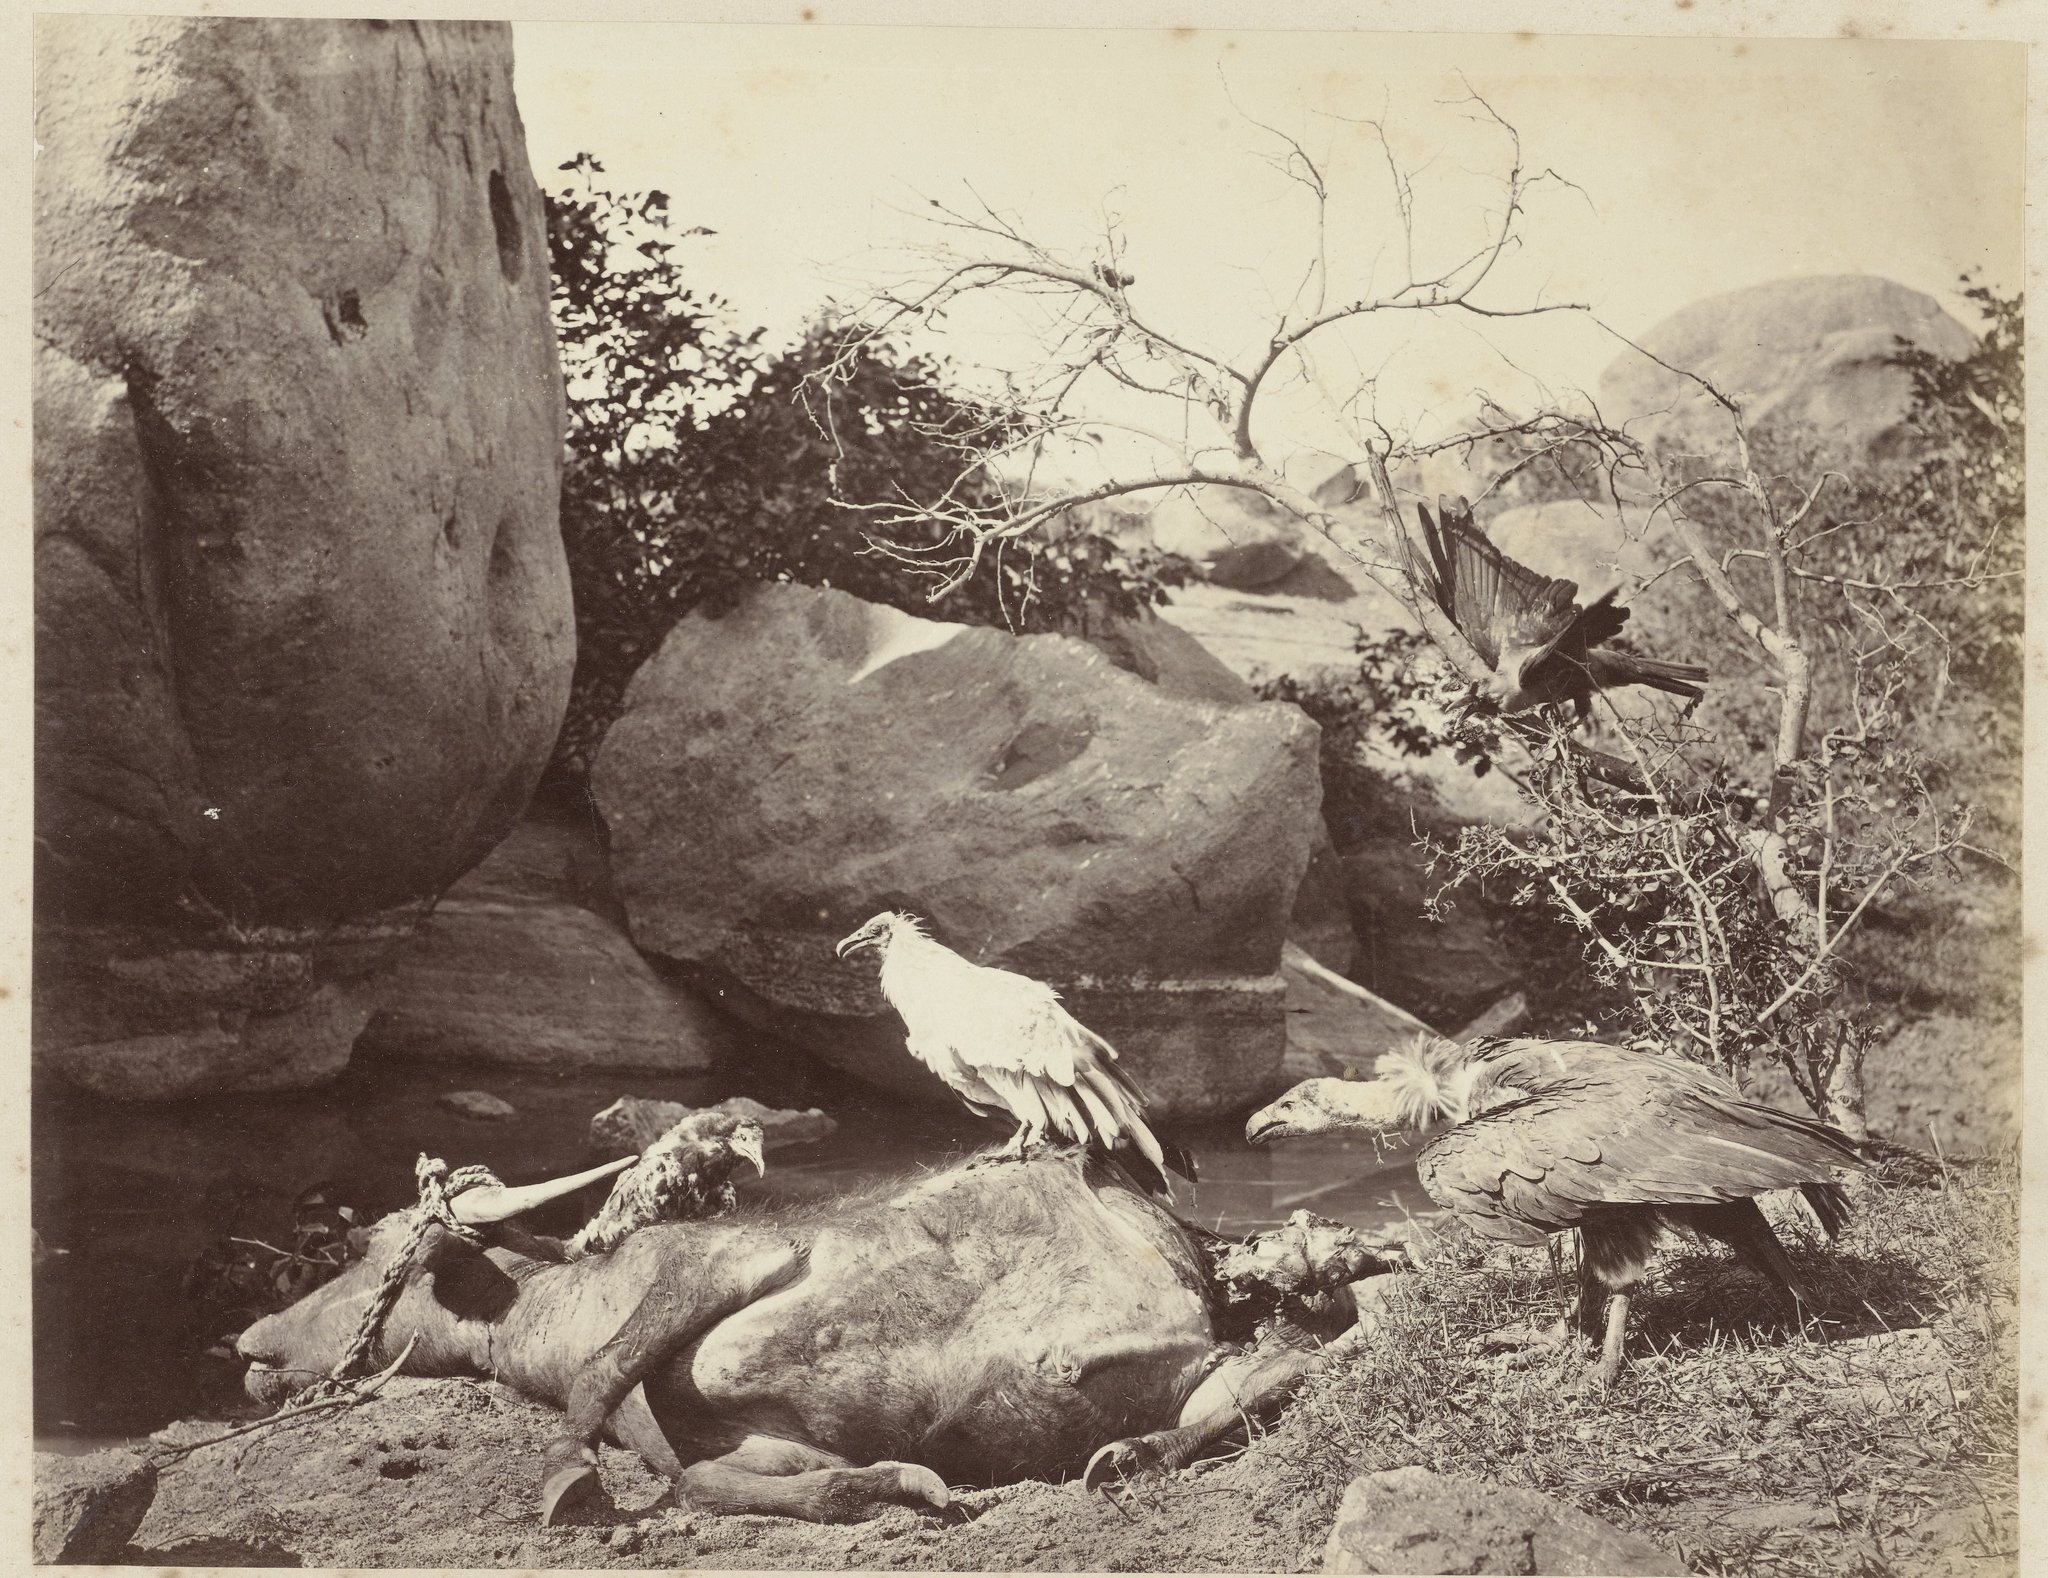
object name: photograph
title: Birds (kite, vulture and crow) near the carcass of a water buffalo, India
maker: willoughby wallace hooper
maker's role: fotograaf, militair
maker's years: 1837-1912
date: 1870-1880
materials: cardboard, paper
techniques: albumen print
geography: india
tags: hoofed animals: buffalo, birds, beasts of prey, predatory animals